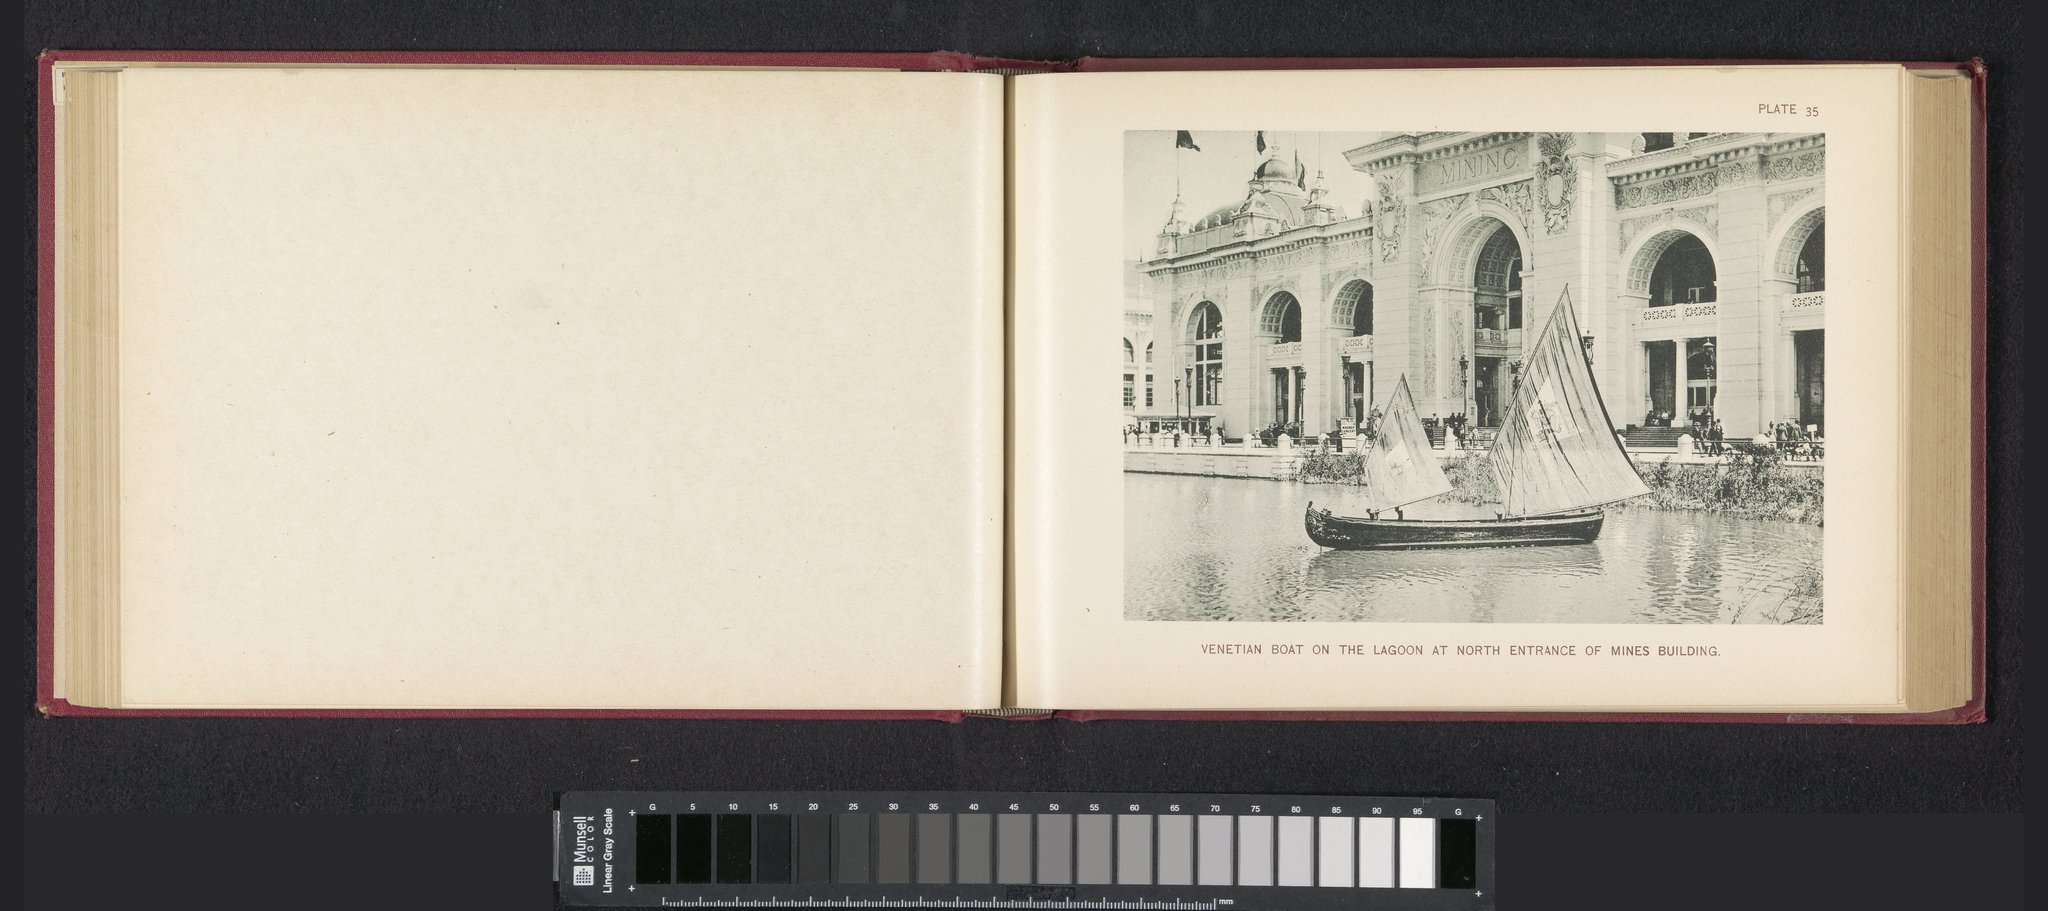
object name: photomechanical print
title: Venetian boat on the lagoon at north entrance of Mines Building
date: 1893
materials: paper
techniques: photograph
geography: chicago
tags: world fair, world exhibition, gondola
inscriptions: number: ‘Plate 35’